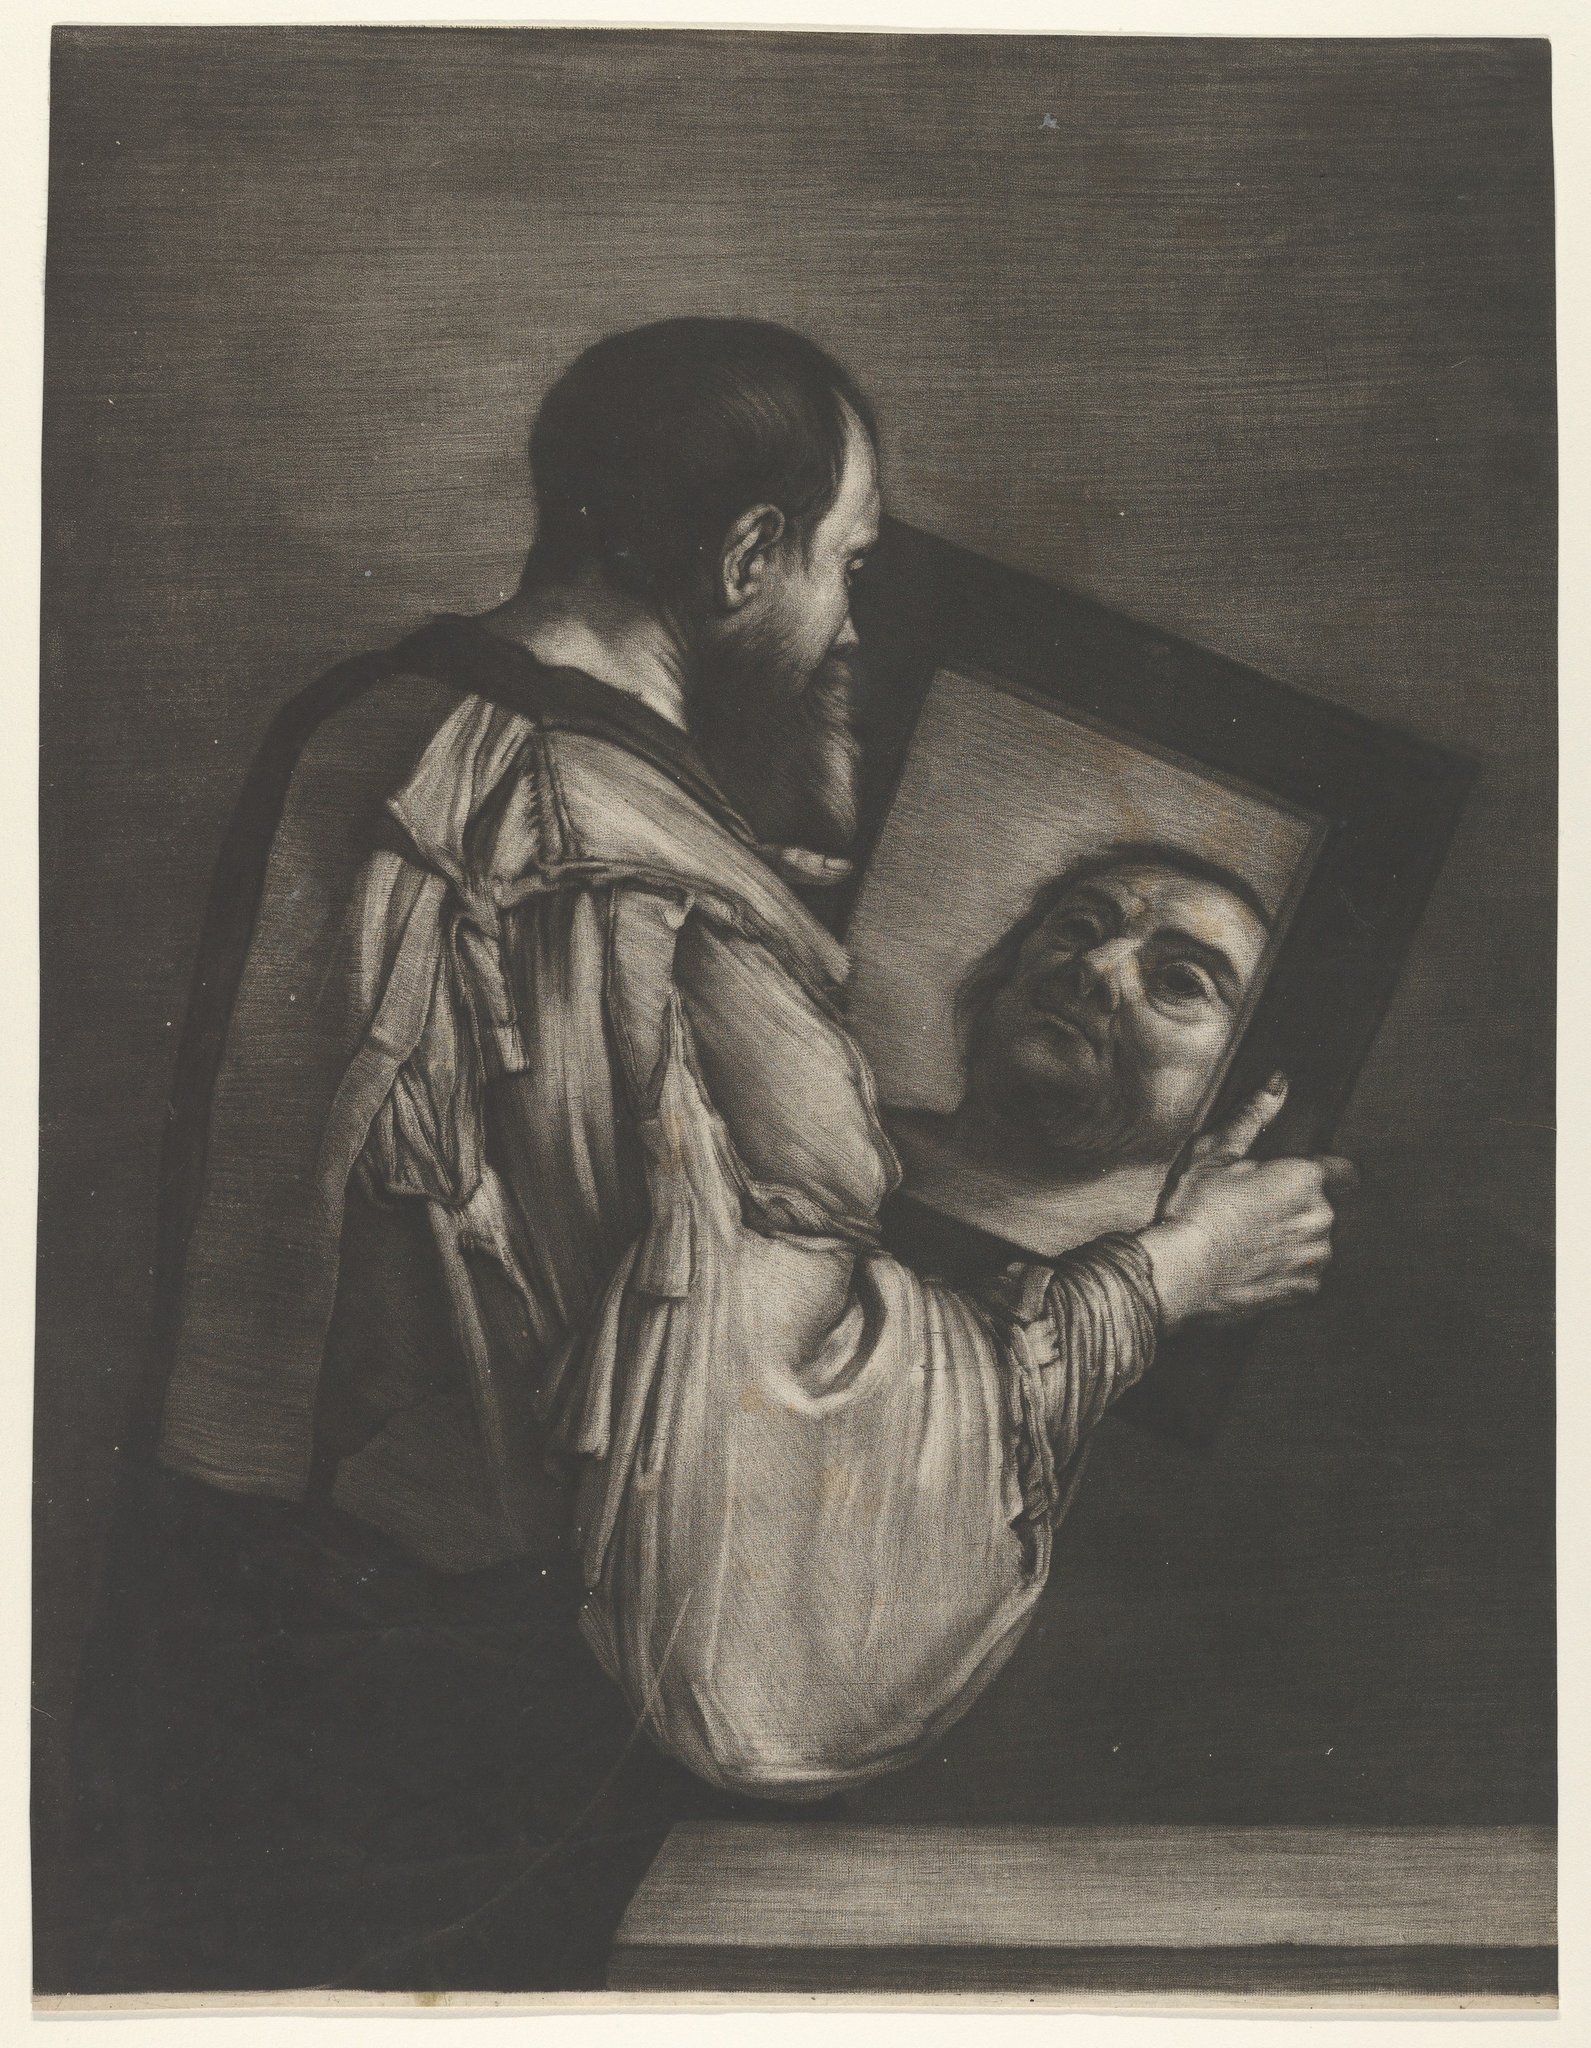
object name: print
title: Socrates Looking in a Mirror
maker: bernard vaillant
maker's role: artist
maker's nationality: dutch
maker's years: 1632-1698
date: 1601-1700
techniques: mezzotint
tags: socrates,mirrors